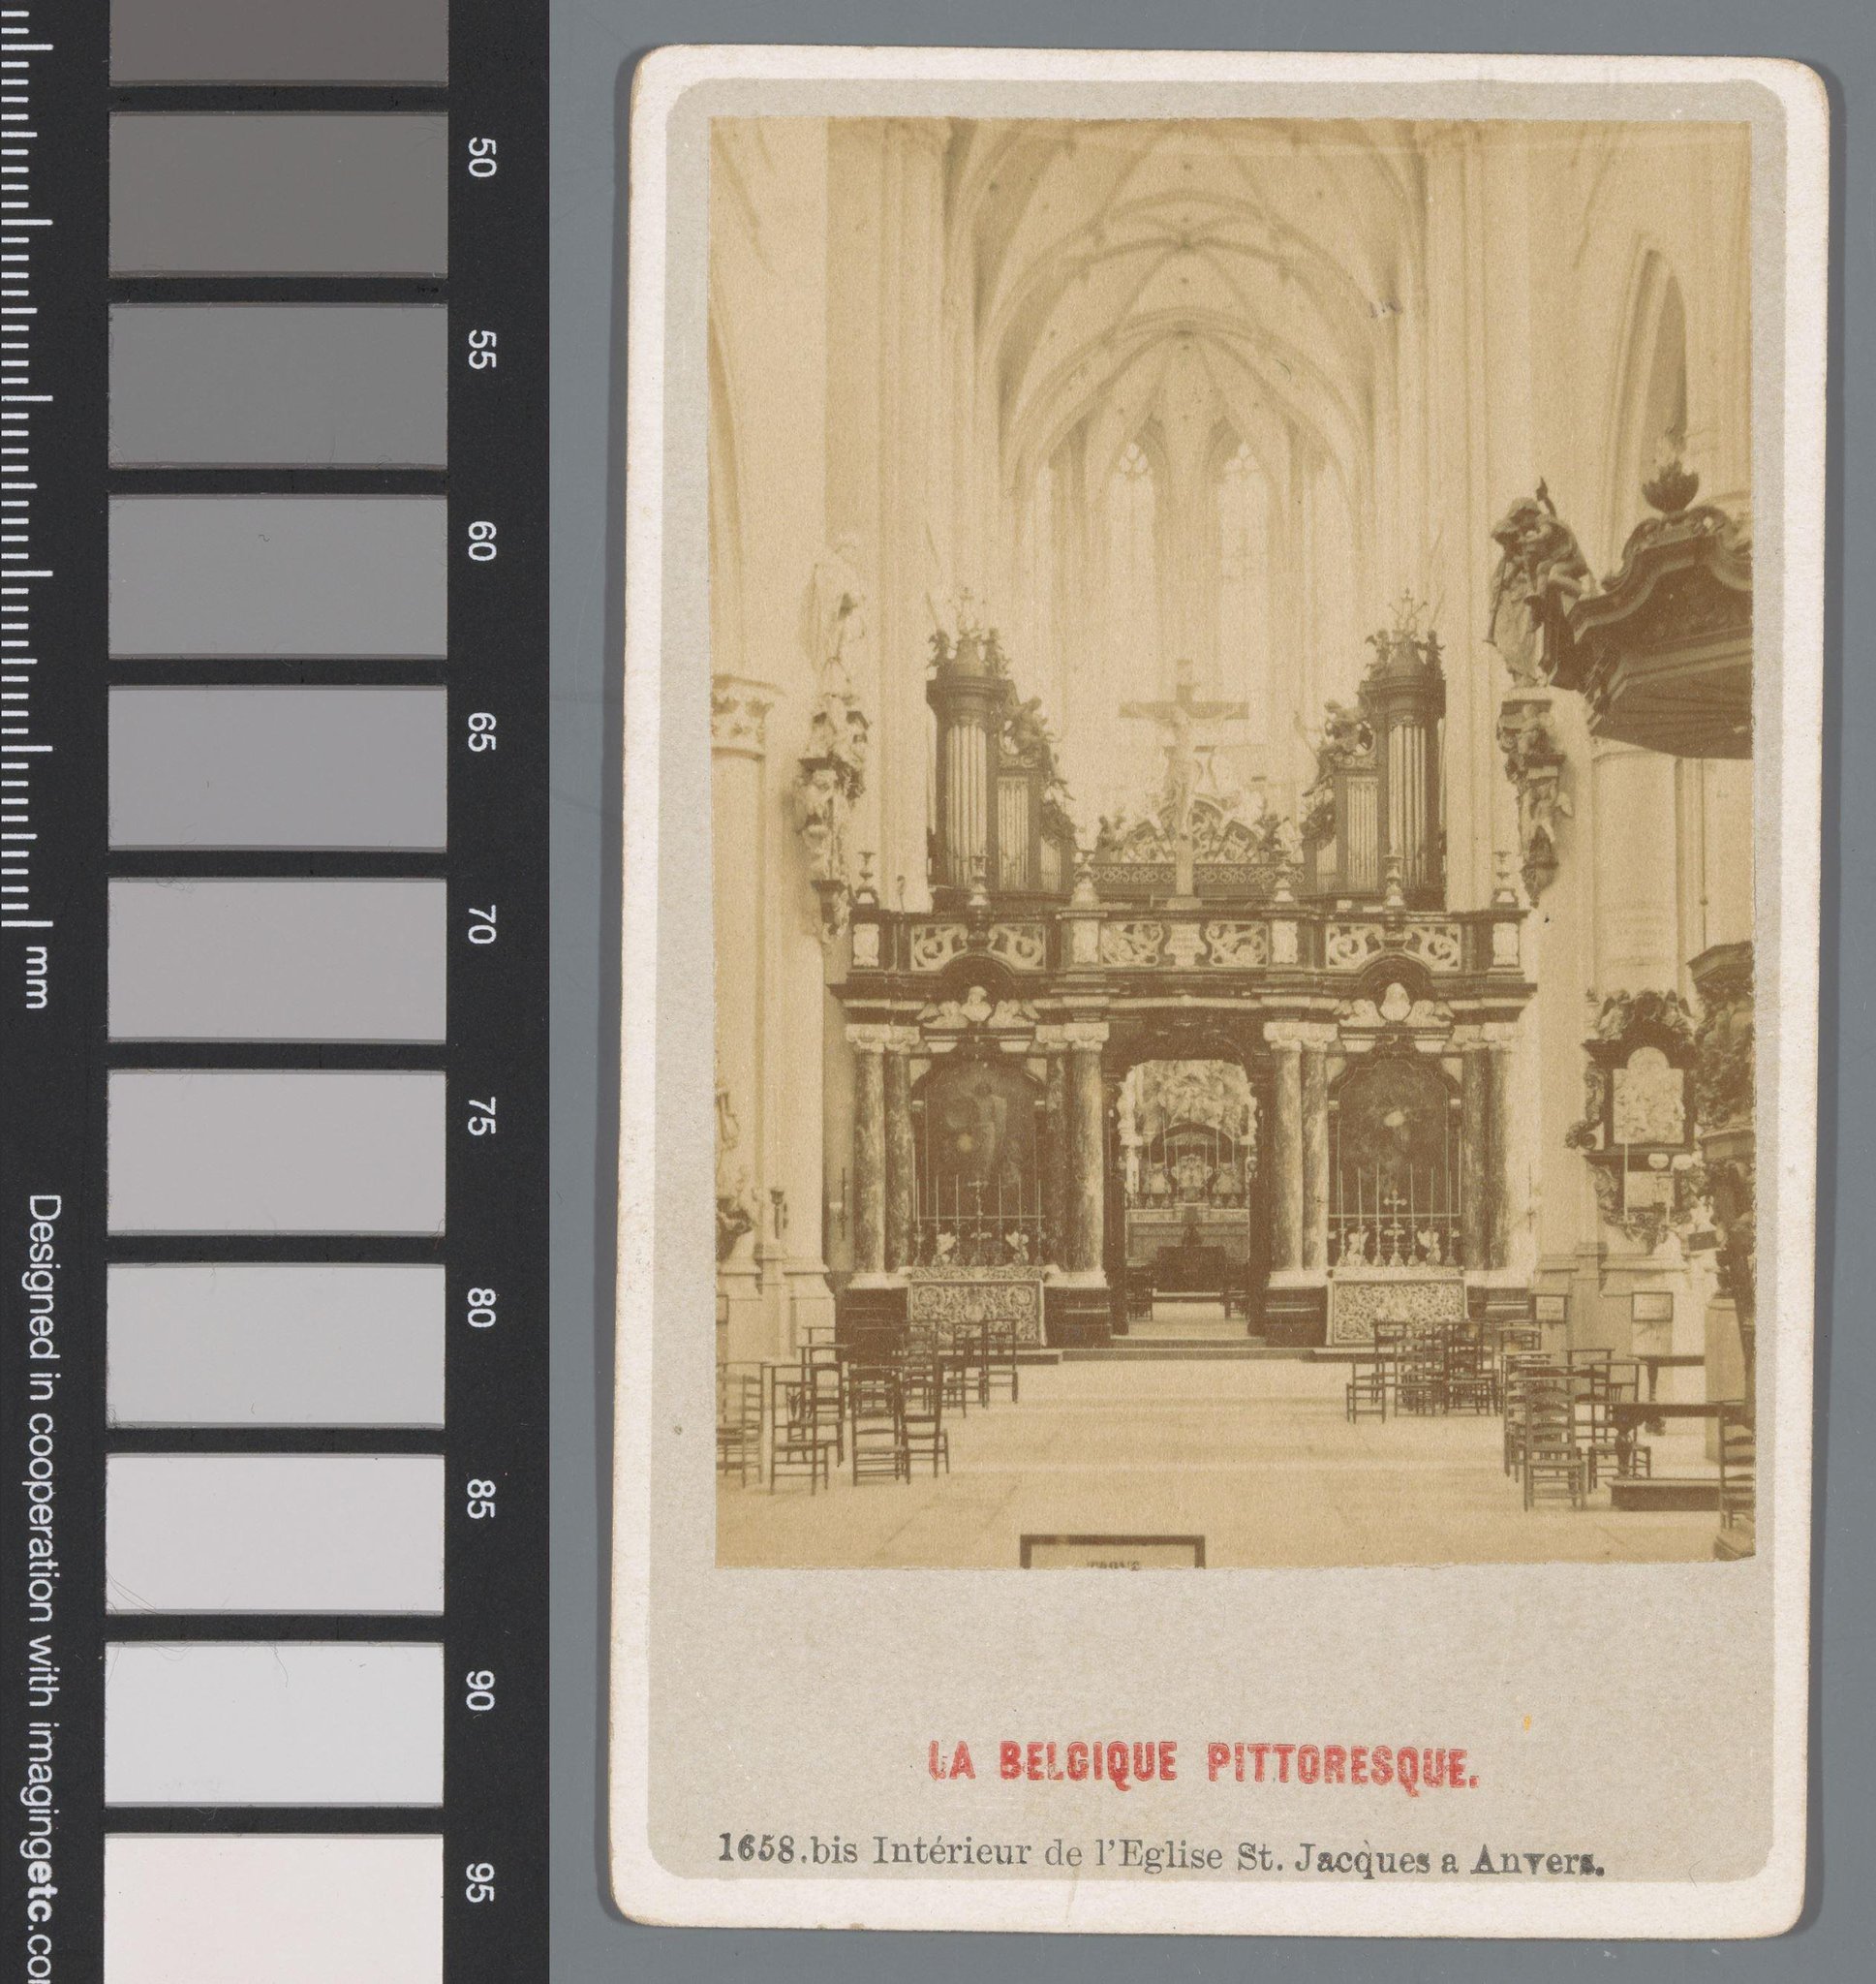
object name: carte de visite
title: Interieur van de Sint-Jacobskerk, Antwerpen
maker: Anonymous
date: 1866-1906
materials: cardboard, paper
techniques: albumen print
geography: antwerp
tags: interior of church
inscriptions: number: ‘1658.’, inscription: ‘Ancienne maison F. Tessaro/ G. Zazzarini & Cie, Successeurs/ 37, Marché aux Souliers/ Anvers’